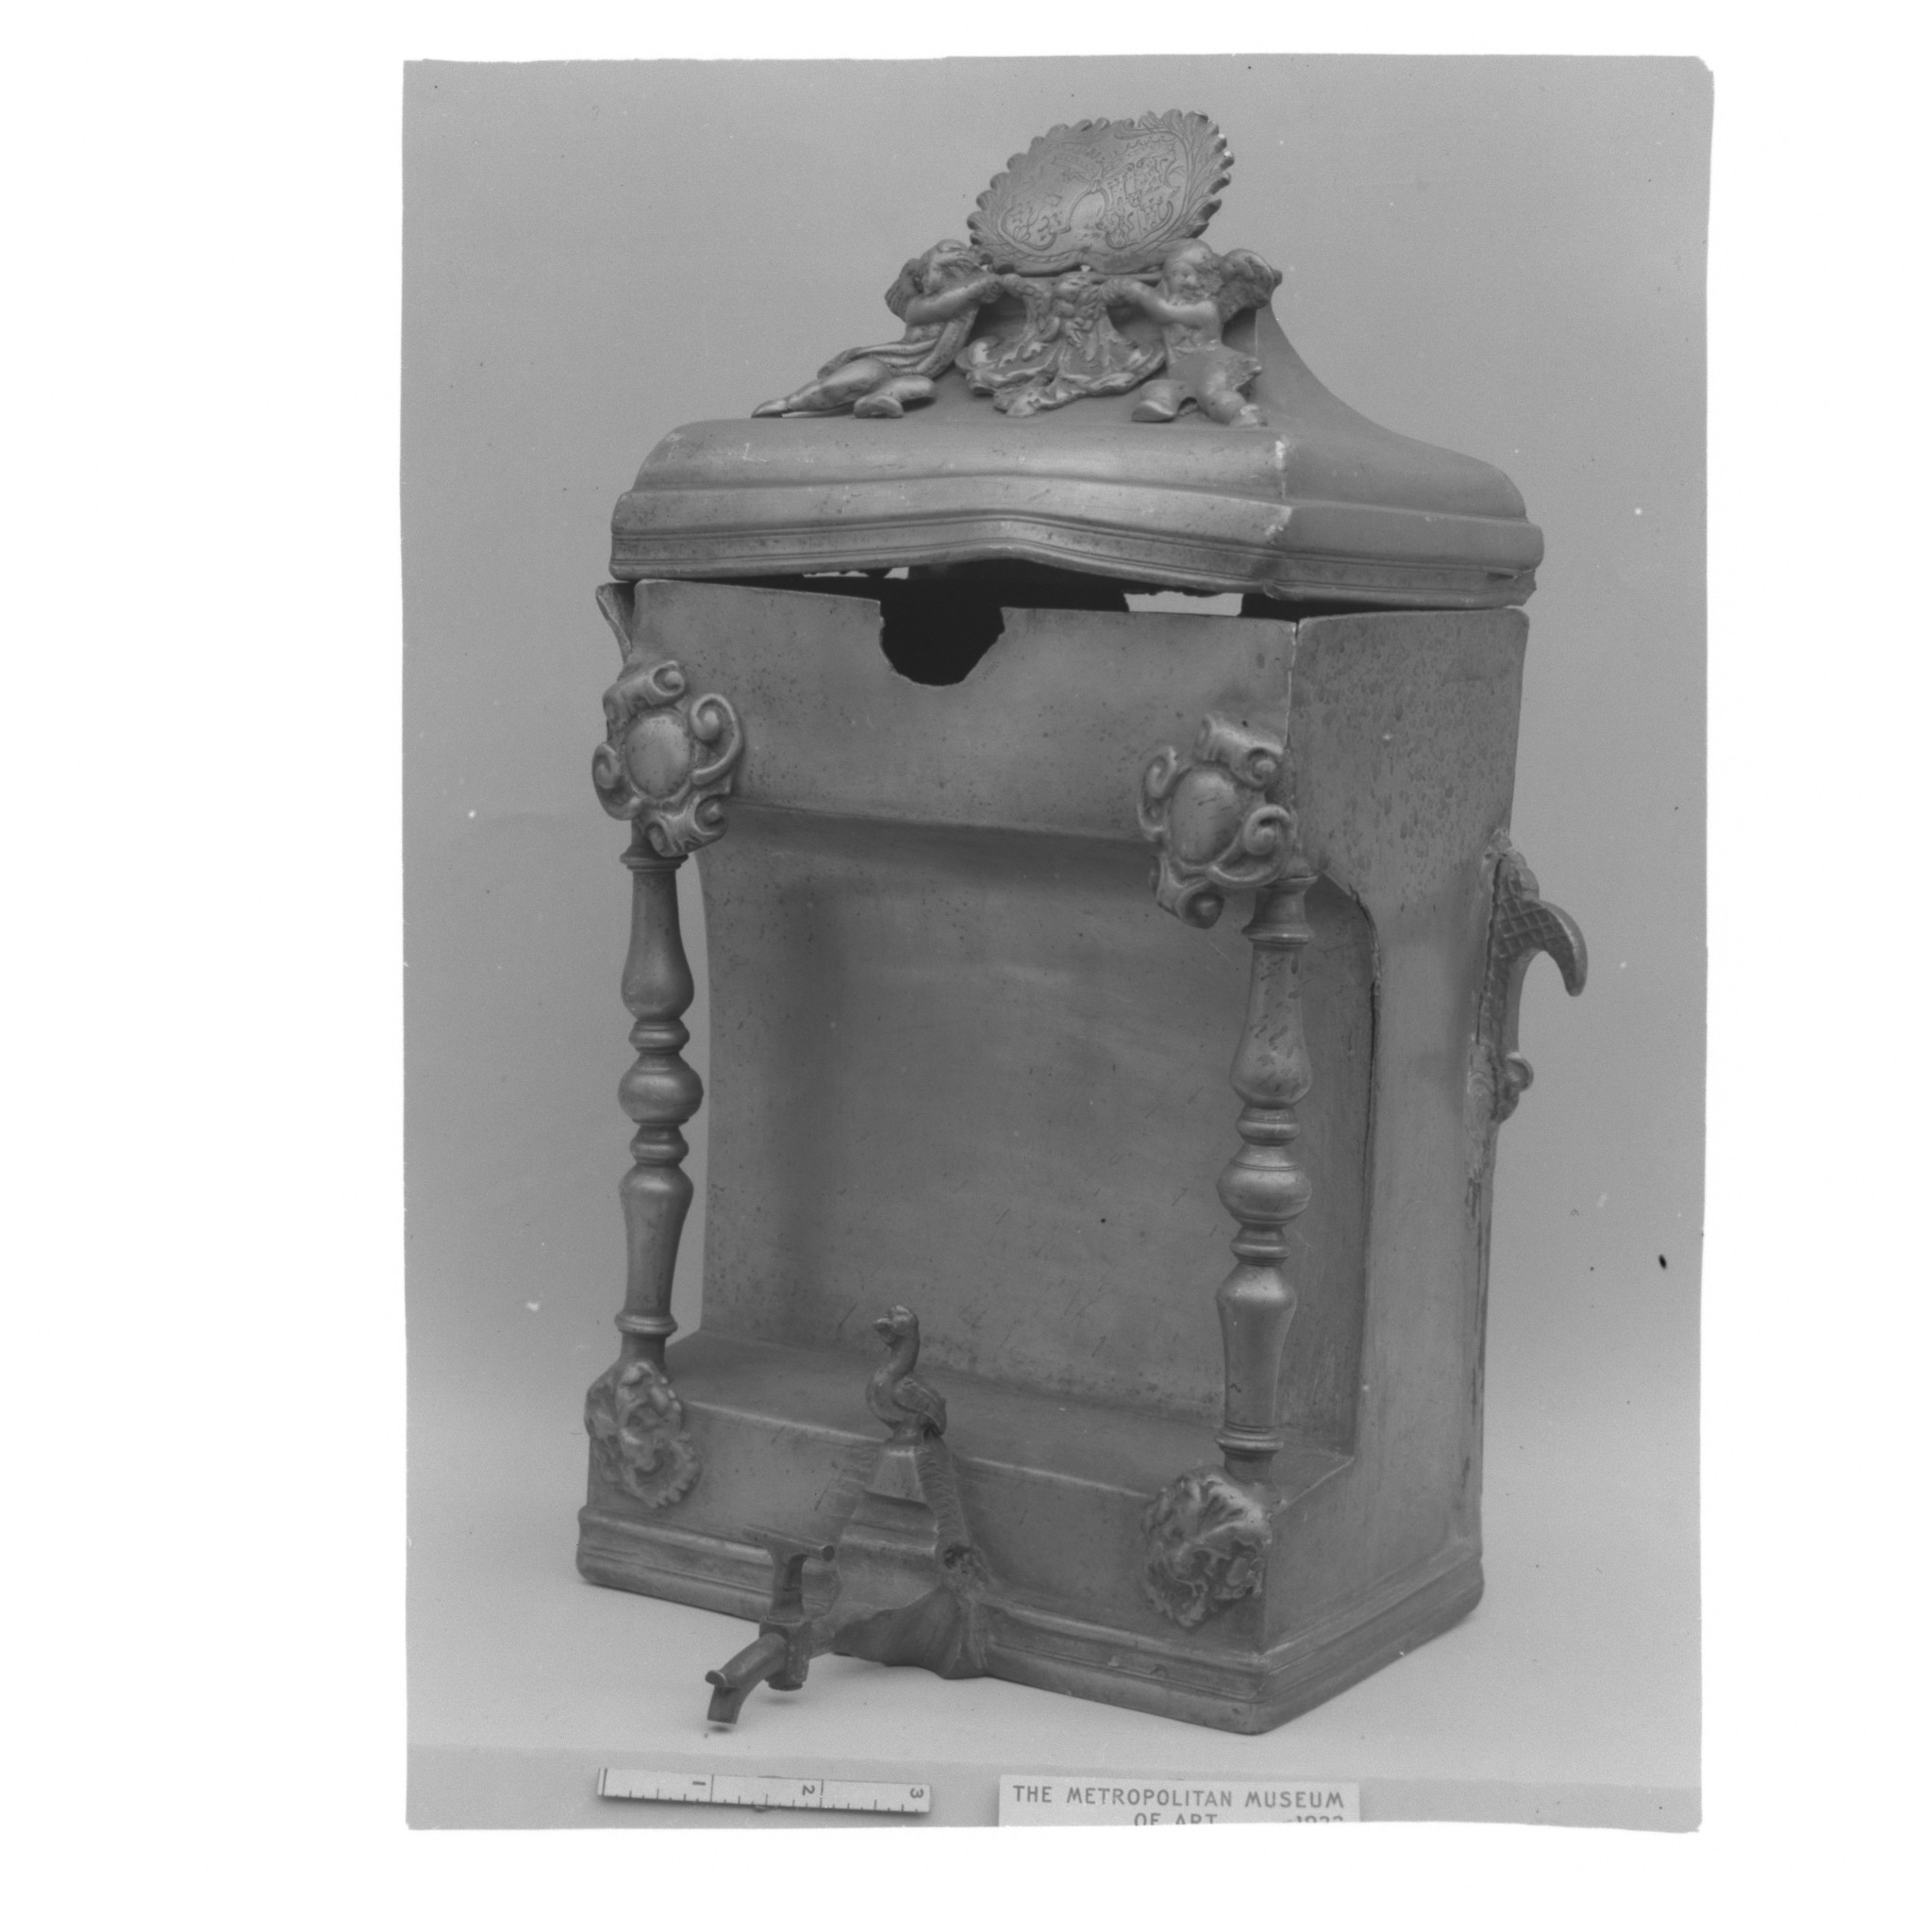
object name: lavabo cistern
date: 1567-1600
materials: pewter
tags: birds,putti